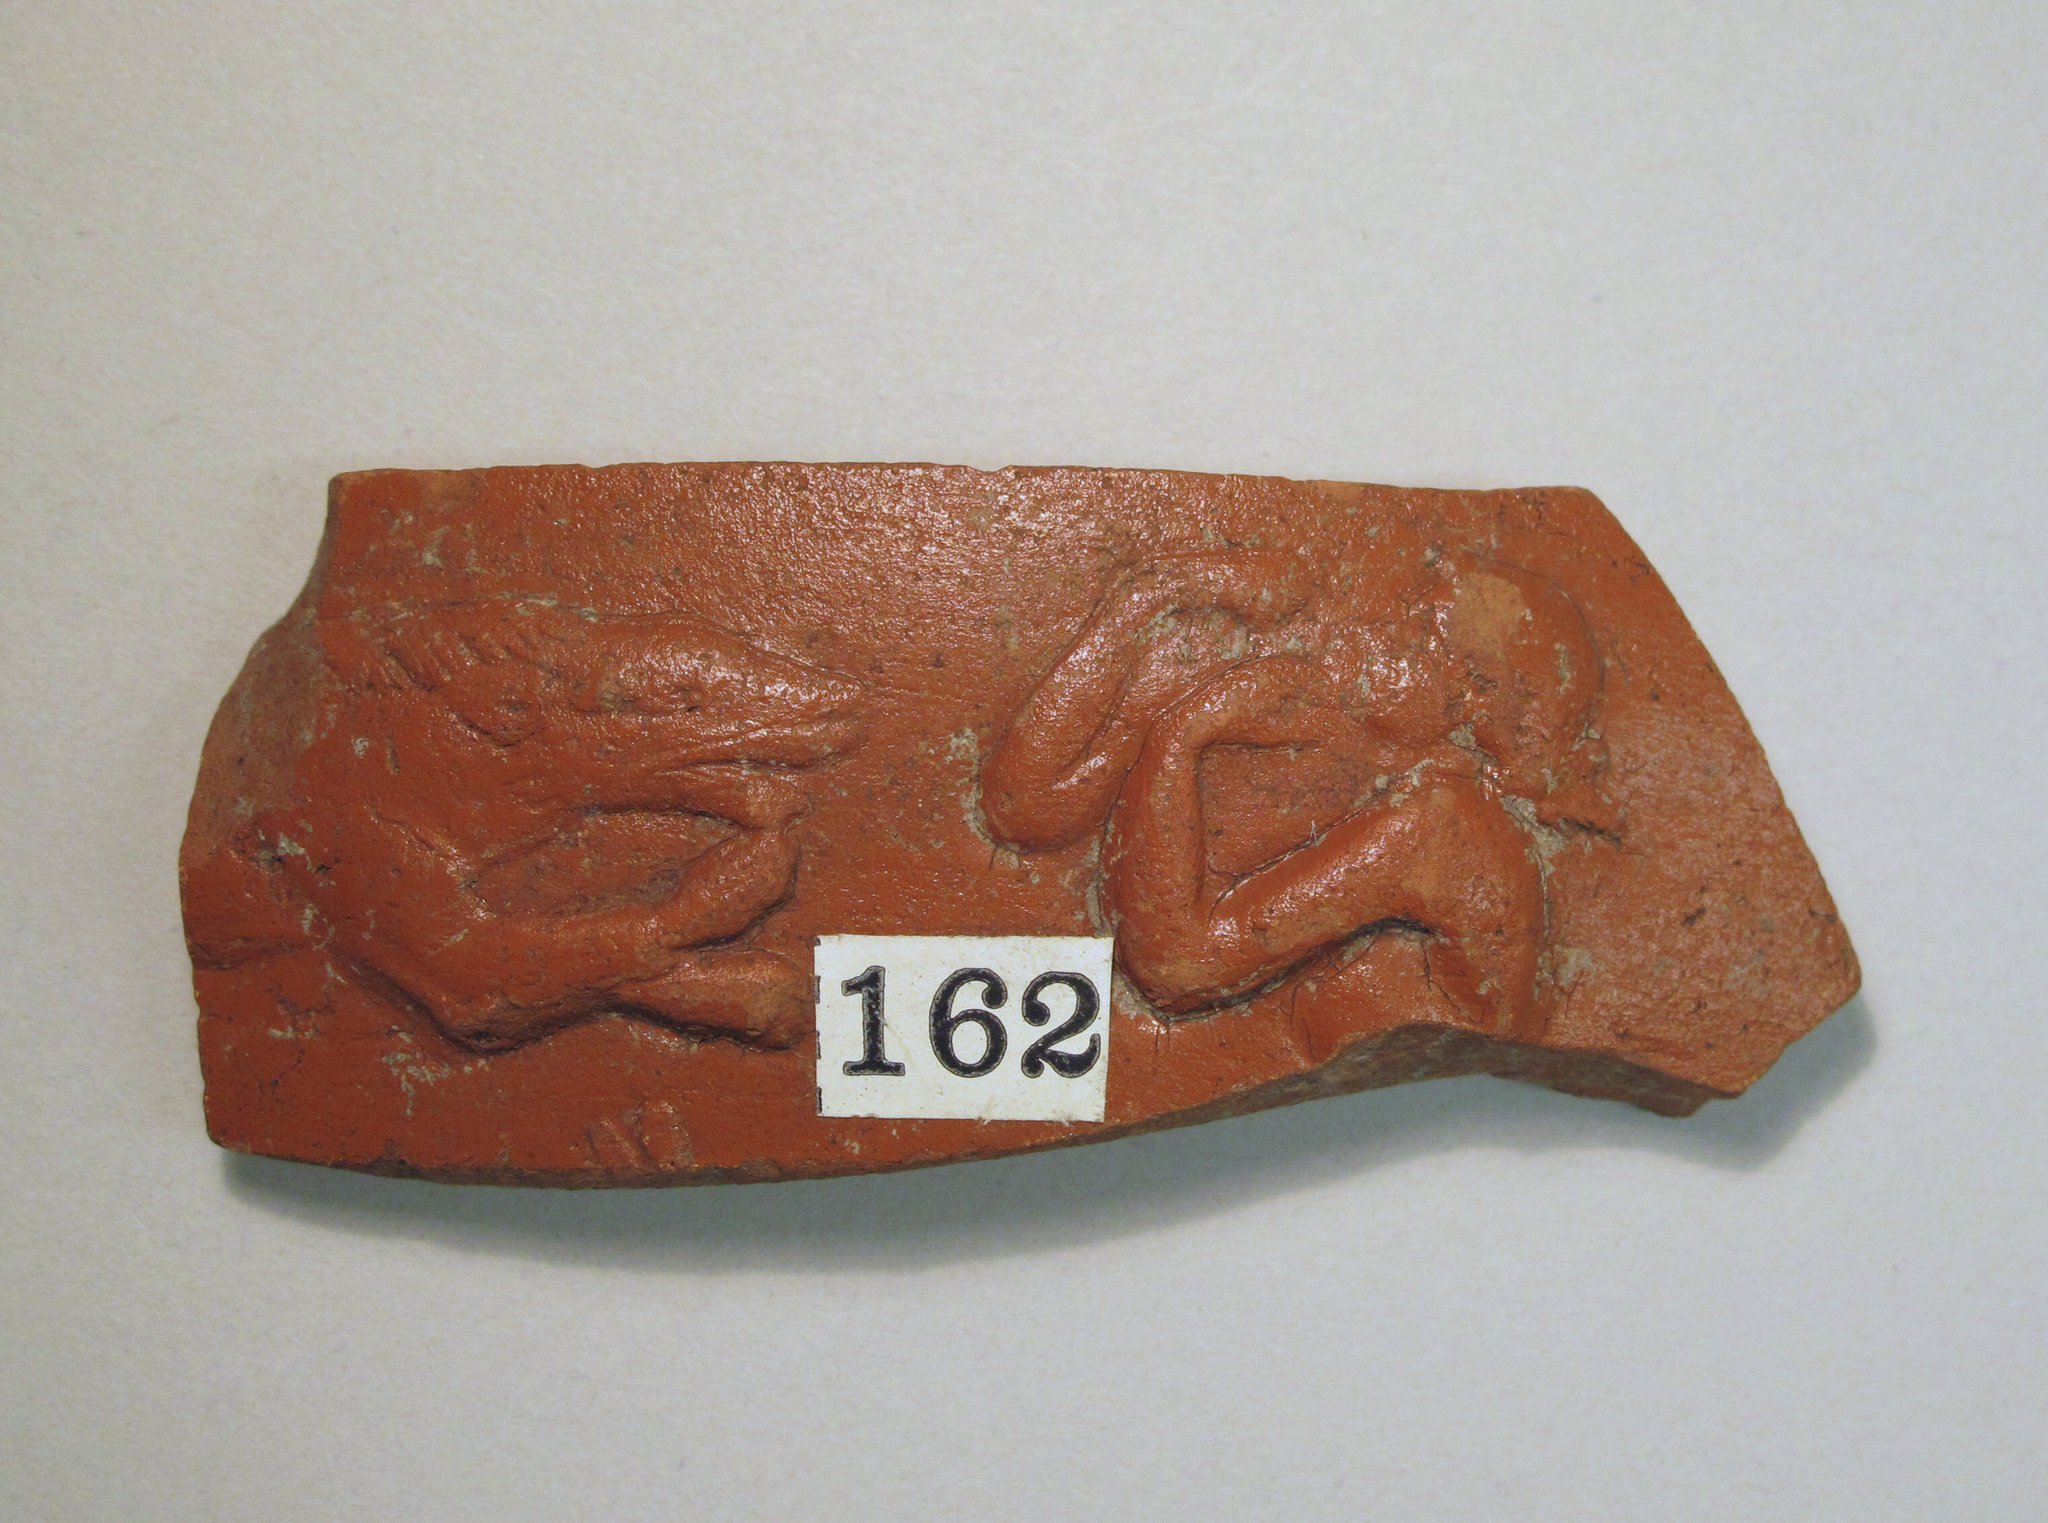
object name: vase fragment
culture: roman, gaul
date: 120 BCE-300 CE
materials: terracotta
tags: animals,men